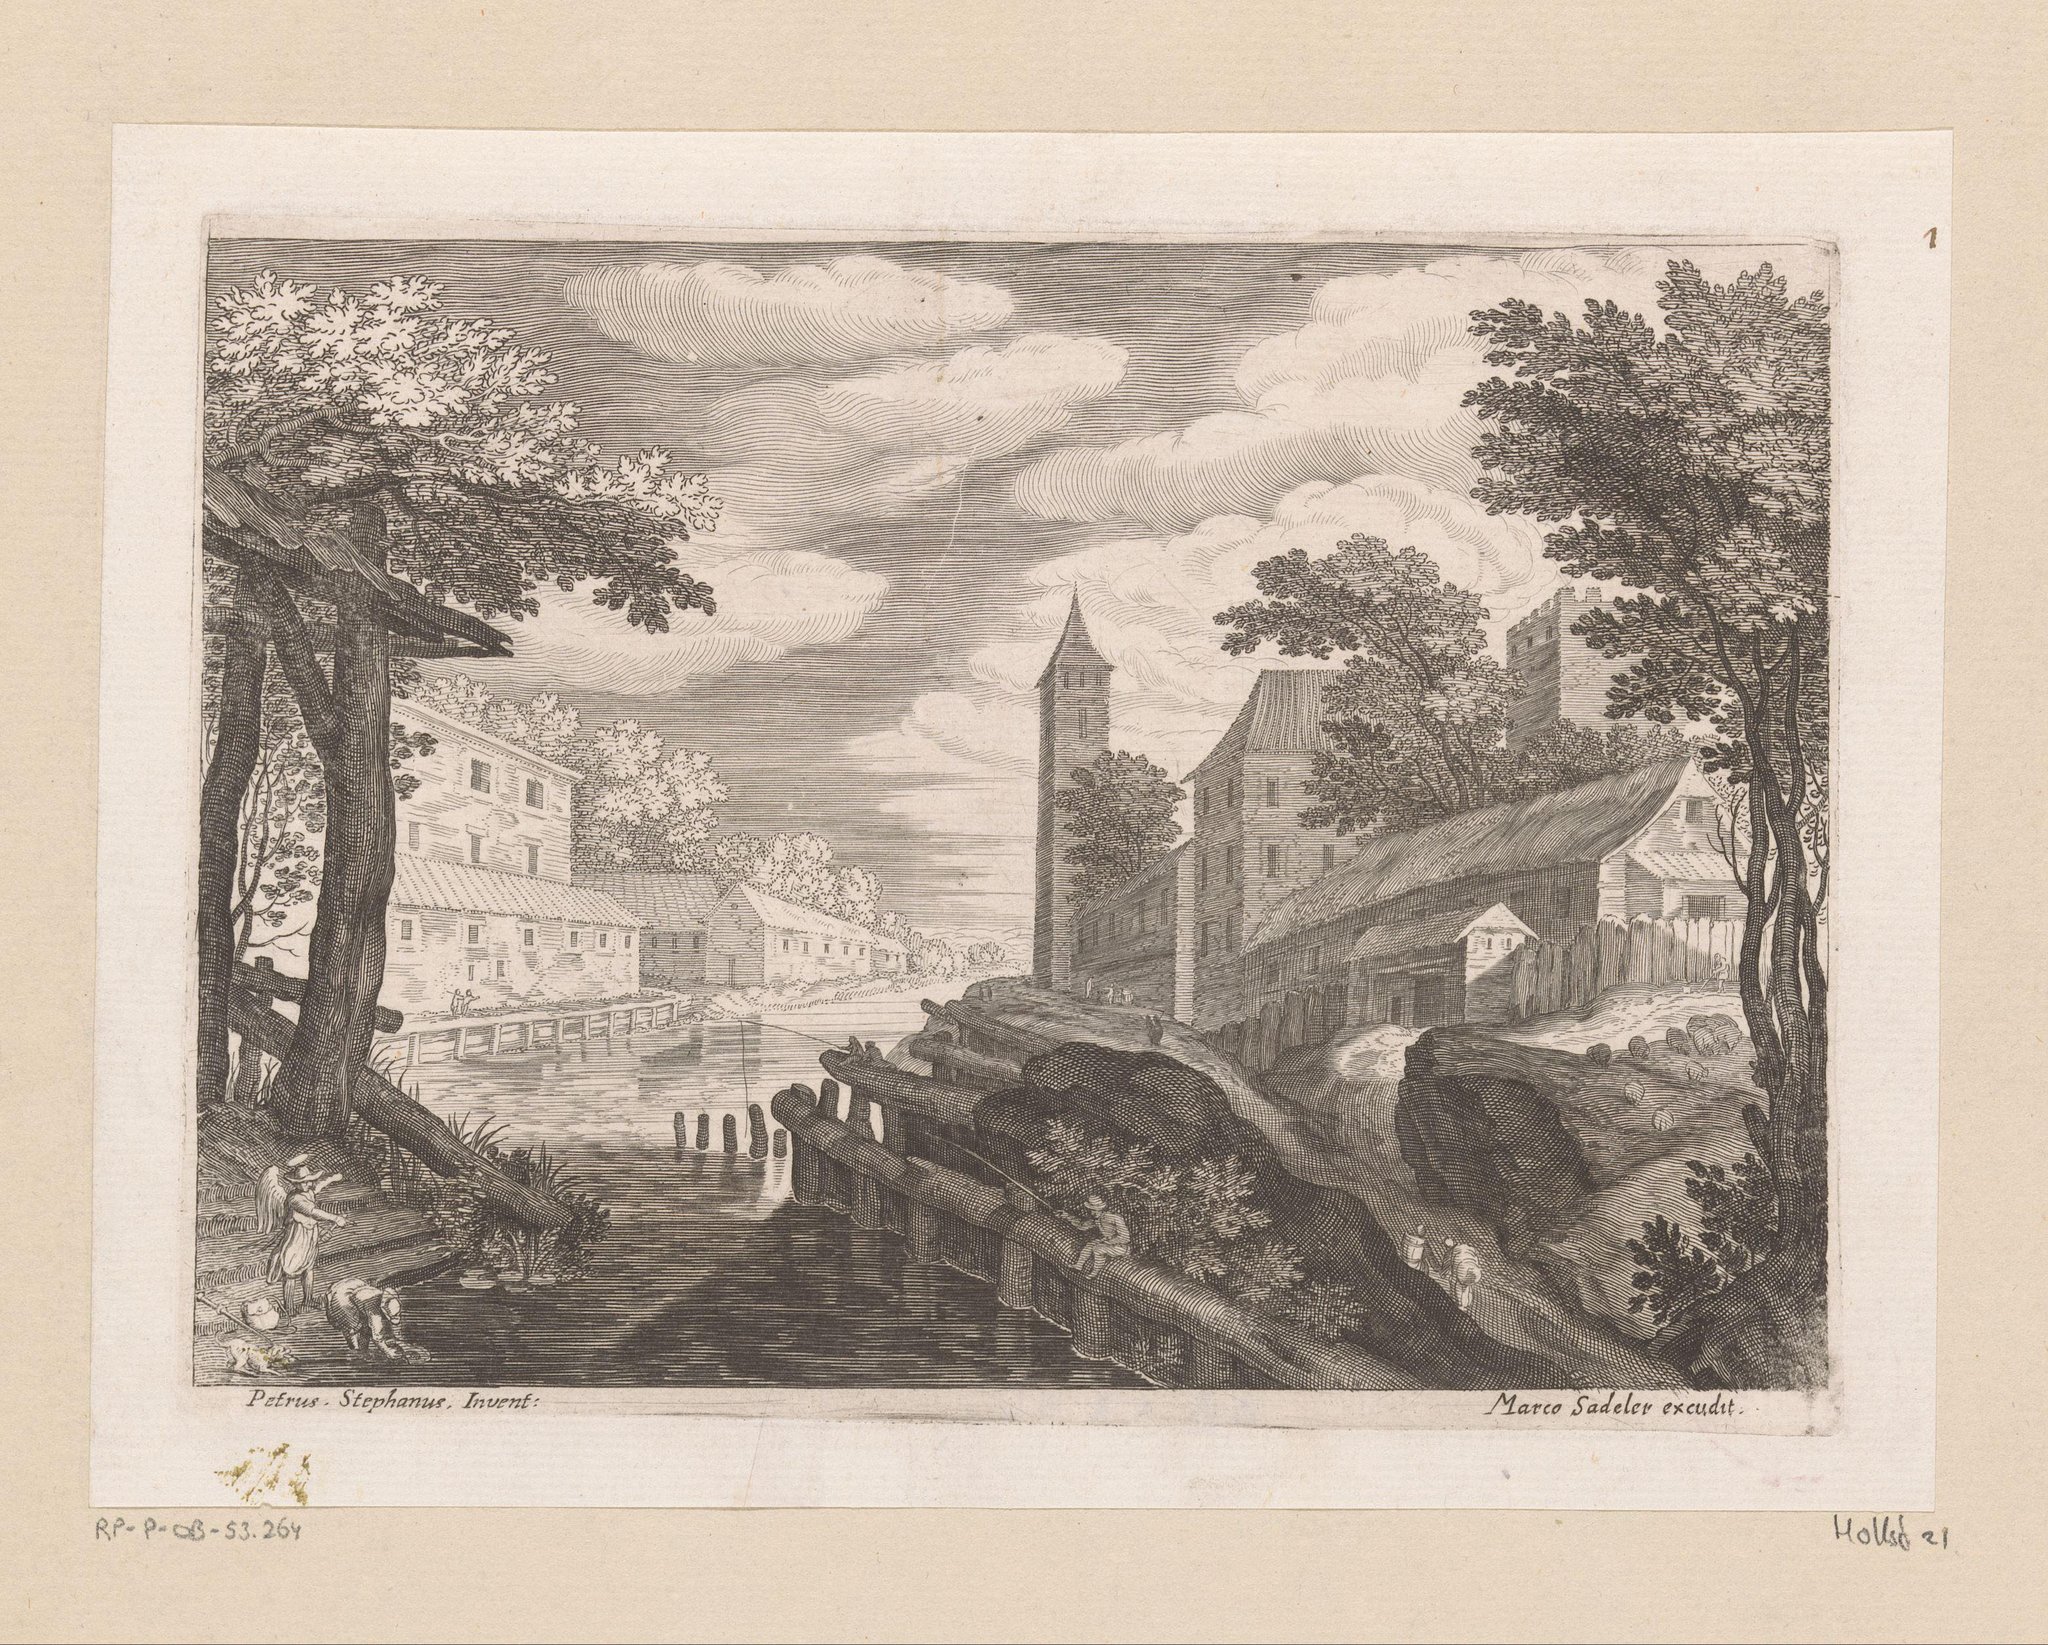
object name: print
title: Kanaal in een dorp met links Tobias en de engel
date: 1586-1630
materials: paper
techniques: engraving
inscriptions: : Lugt 240